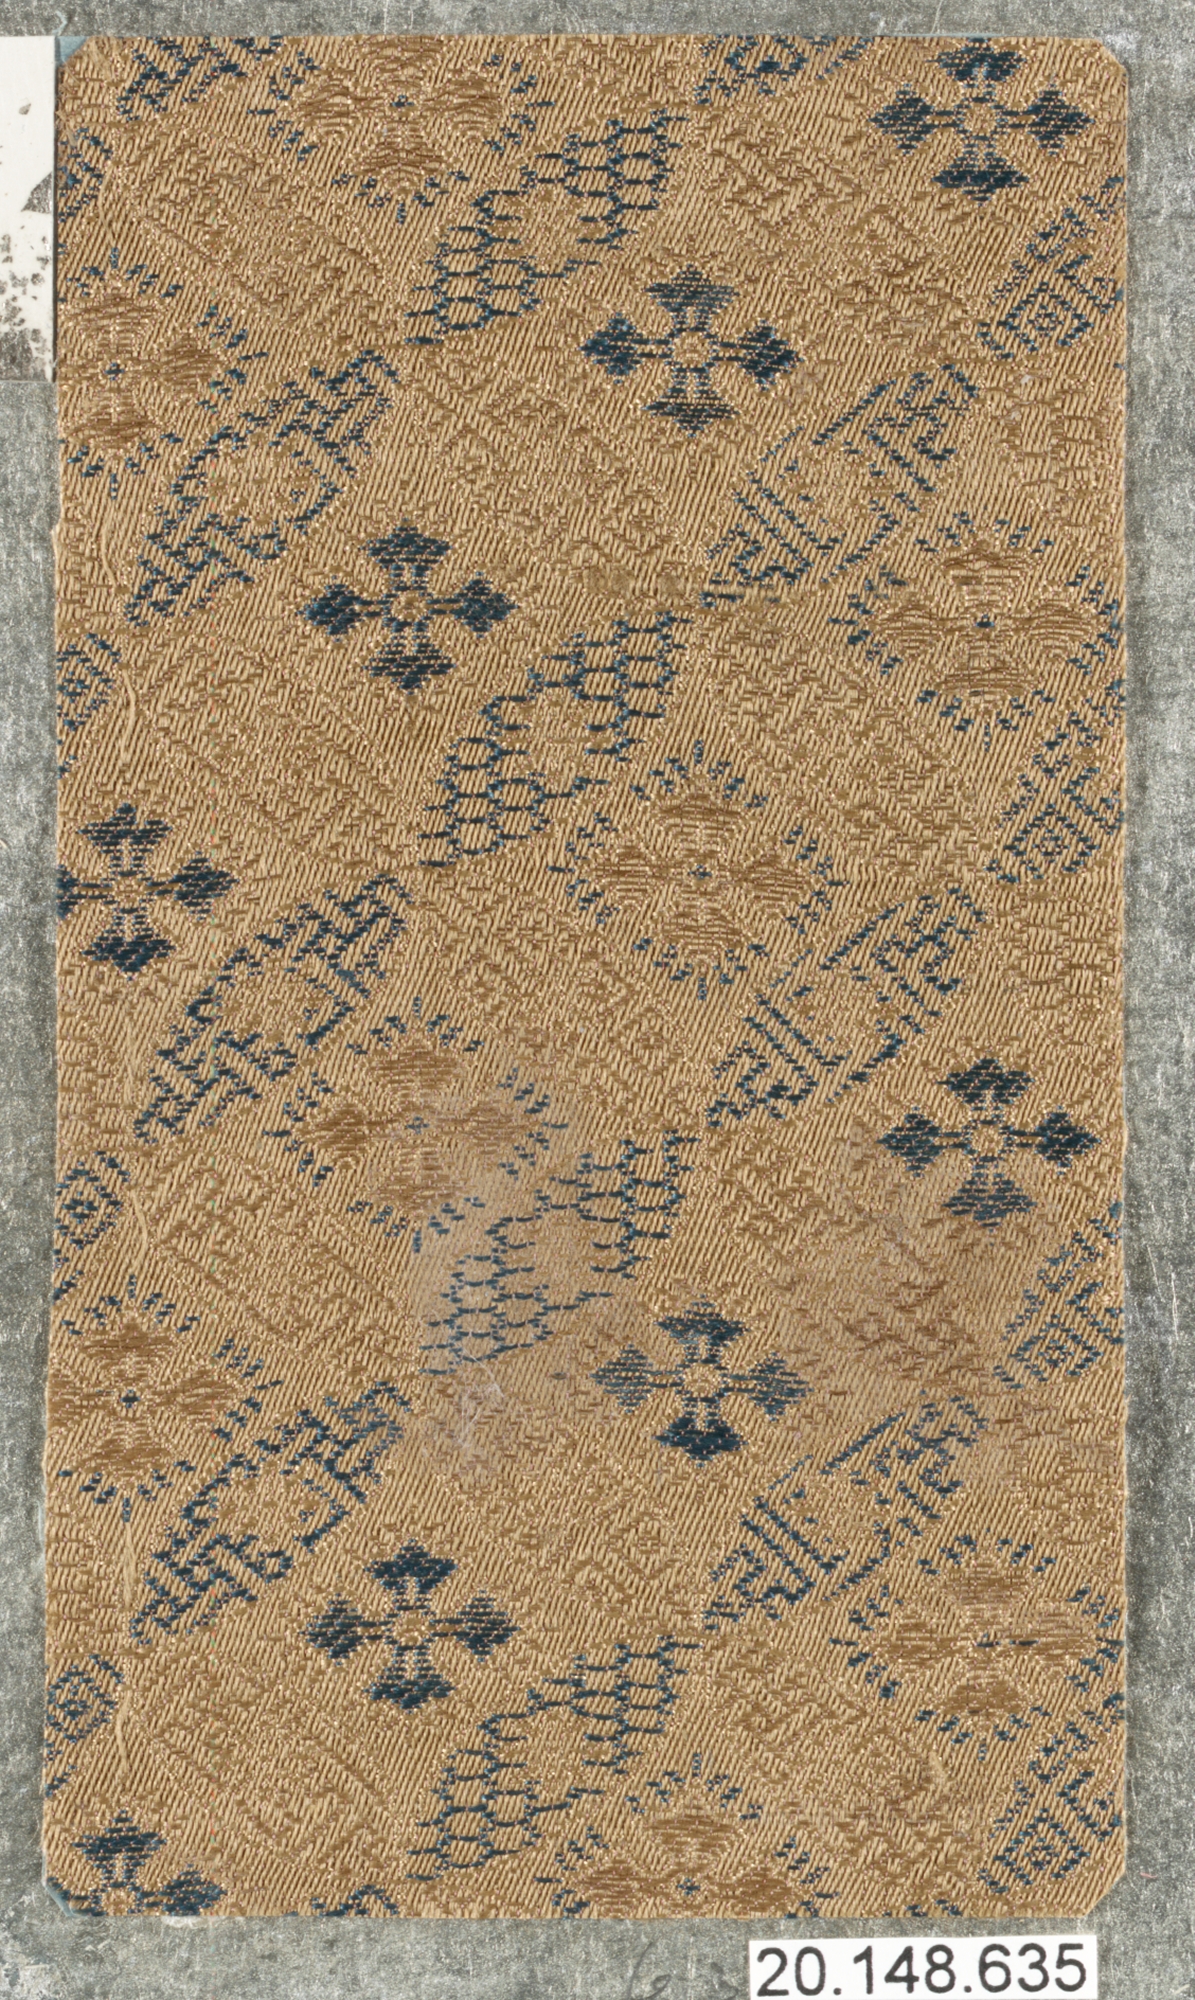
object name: piece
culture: japanese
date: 1701-1800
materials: silk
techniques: compound weave